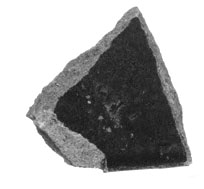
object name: shard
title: Shard (Study Collection)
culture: chinese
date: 1644-1911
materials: ceramic, glaze